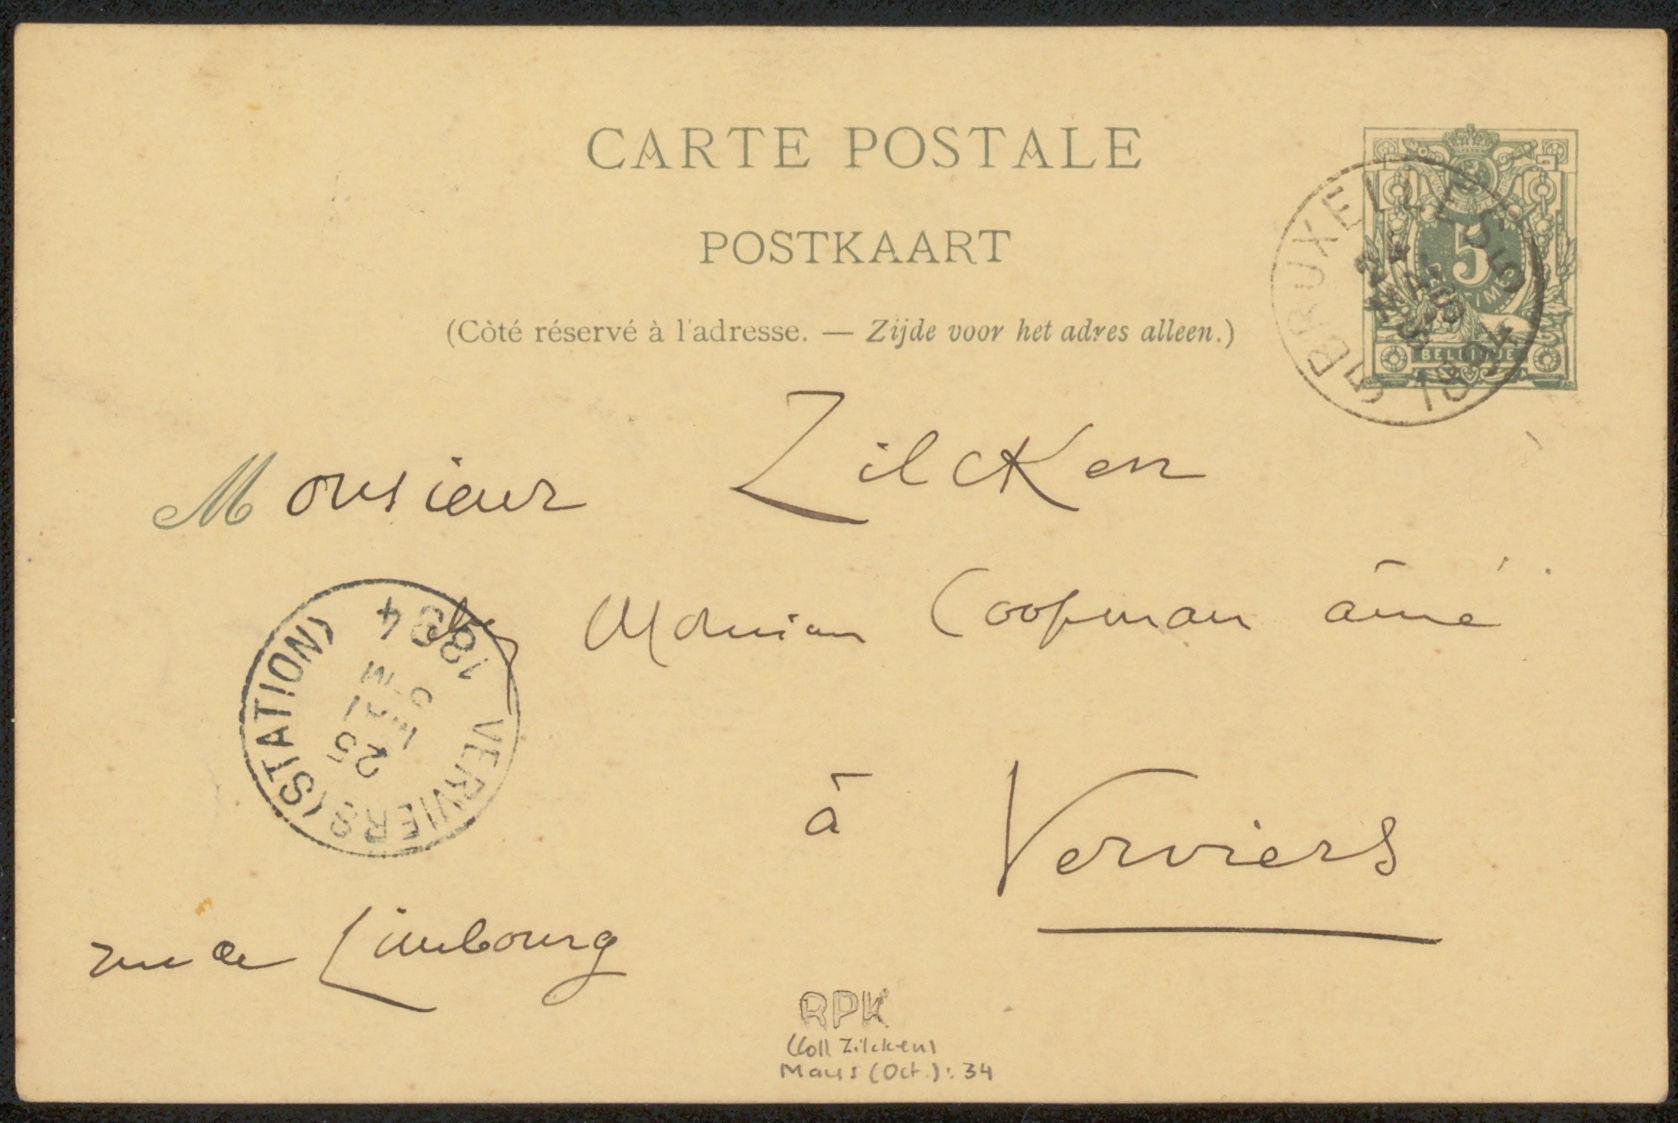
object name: postcard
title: Briefkaart aan Philip Zilcken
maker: octave maus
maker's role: painter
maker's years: 1856-1919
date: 1894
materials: cardboard, ink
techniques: pen, writing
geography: brussels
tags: the hague, draughtsman, philip zilcken, printed matter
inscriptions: collector's mark: ‘RPK’